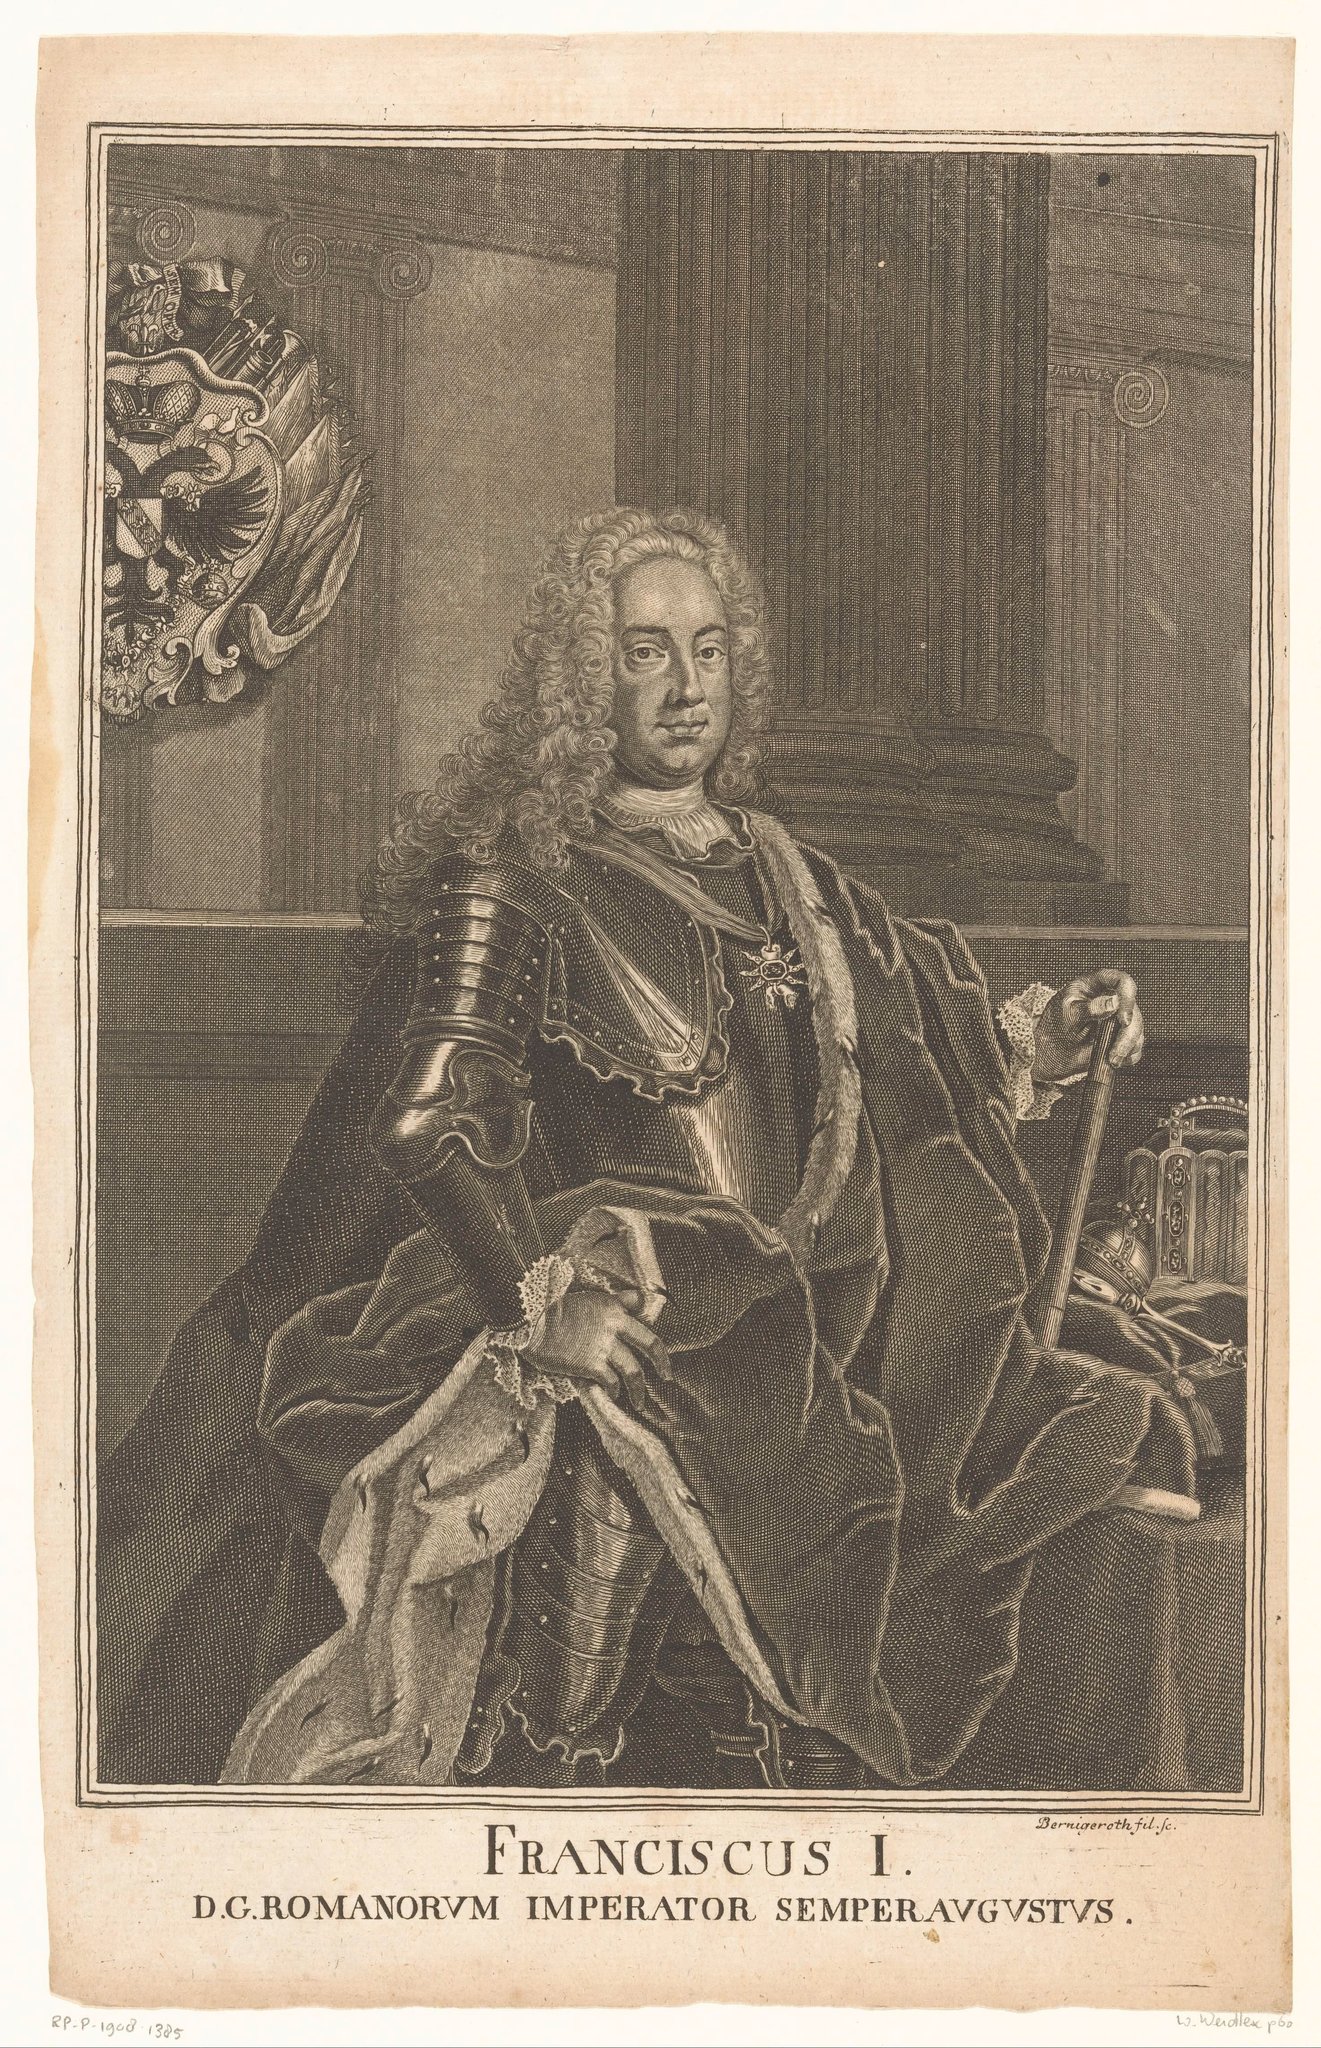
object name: print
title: Portret van Franz I Stephan, Rooms-Duits keizer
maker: johann martin bernigeroth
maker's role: print maker, publisher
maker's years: 1713-1767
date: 1745-1767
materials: paper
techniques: engraving, etching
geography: leipzig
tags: frans i stefan (duits keizer), armour, historical persons, knighthood order of the golden fleece, armorial bearing, heraldry, insignia and symbols of sovereignty (crown, diadem, sceptre, orb, seal, standard, cloak, pectoral)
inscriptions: collector's mark: Lugt 2228